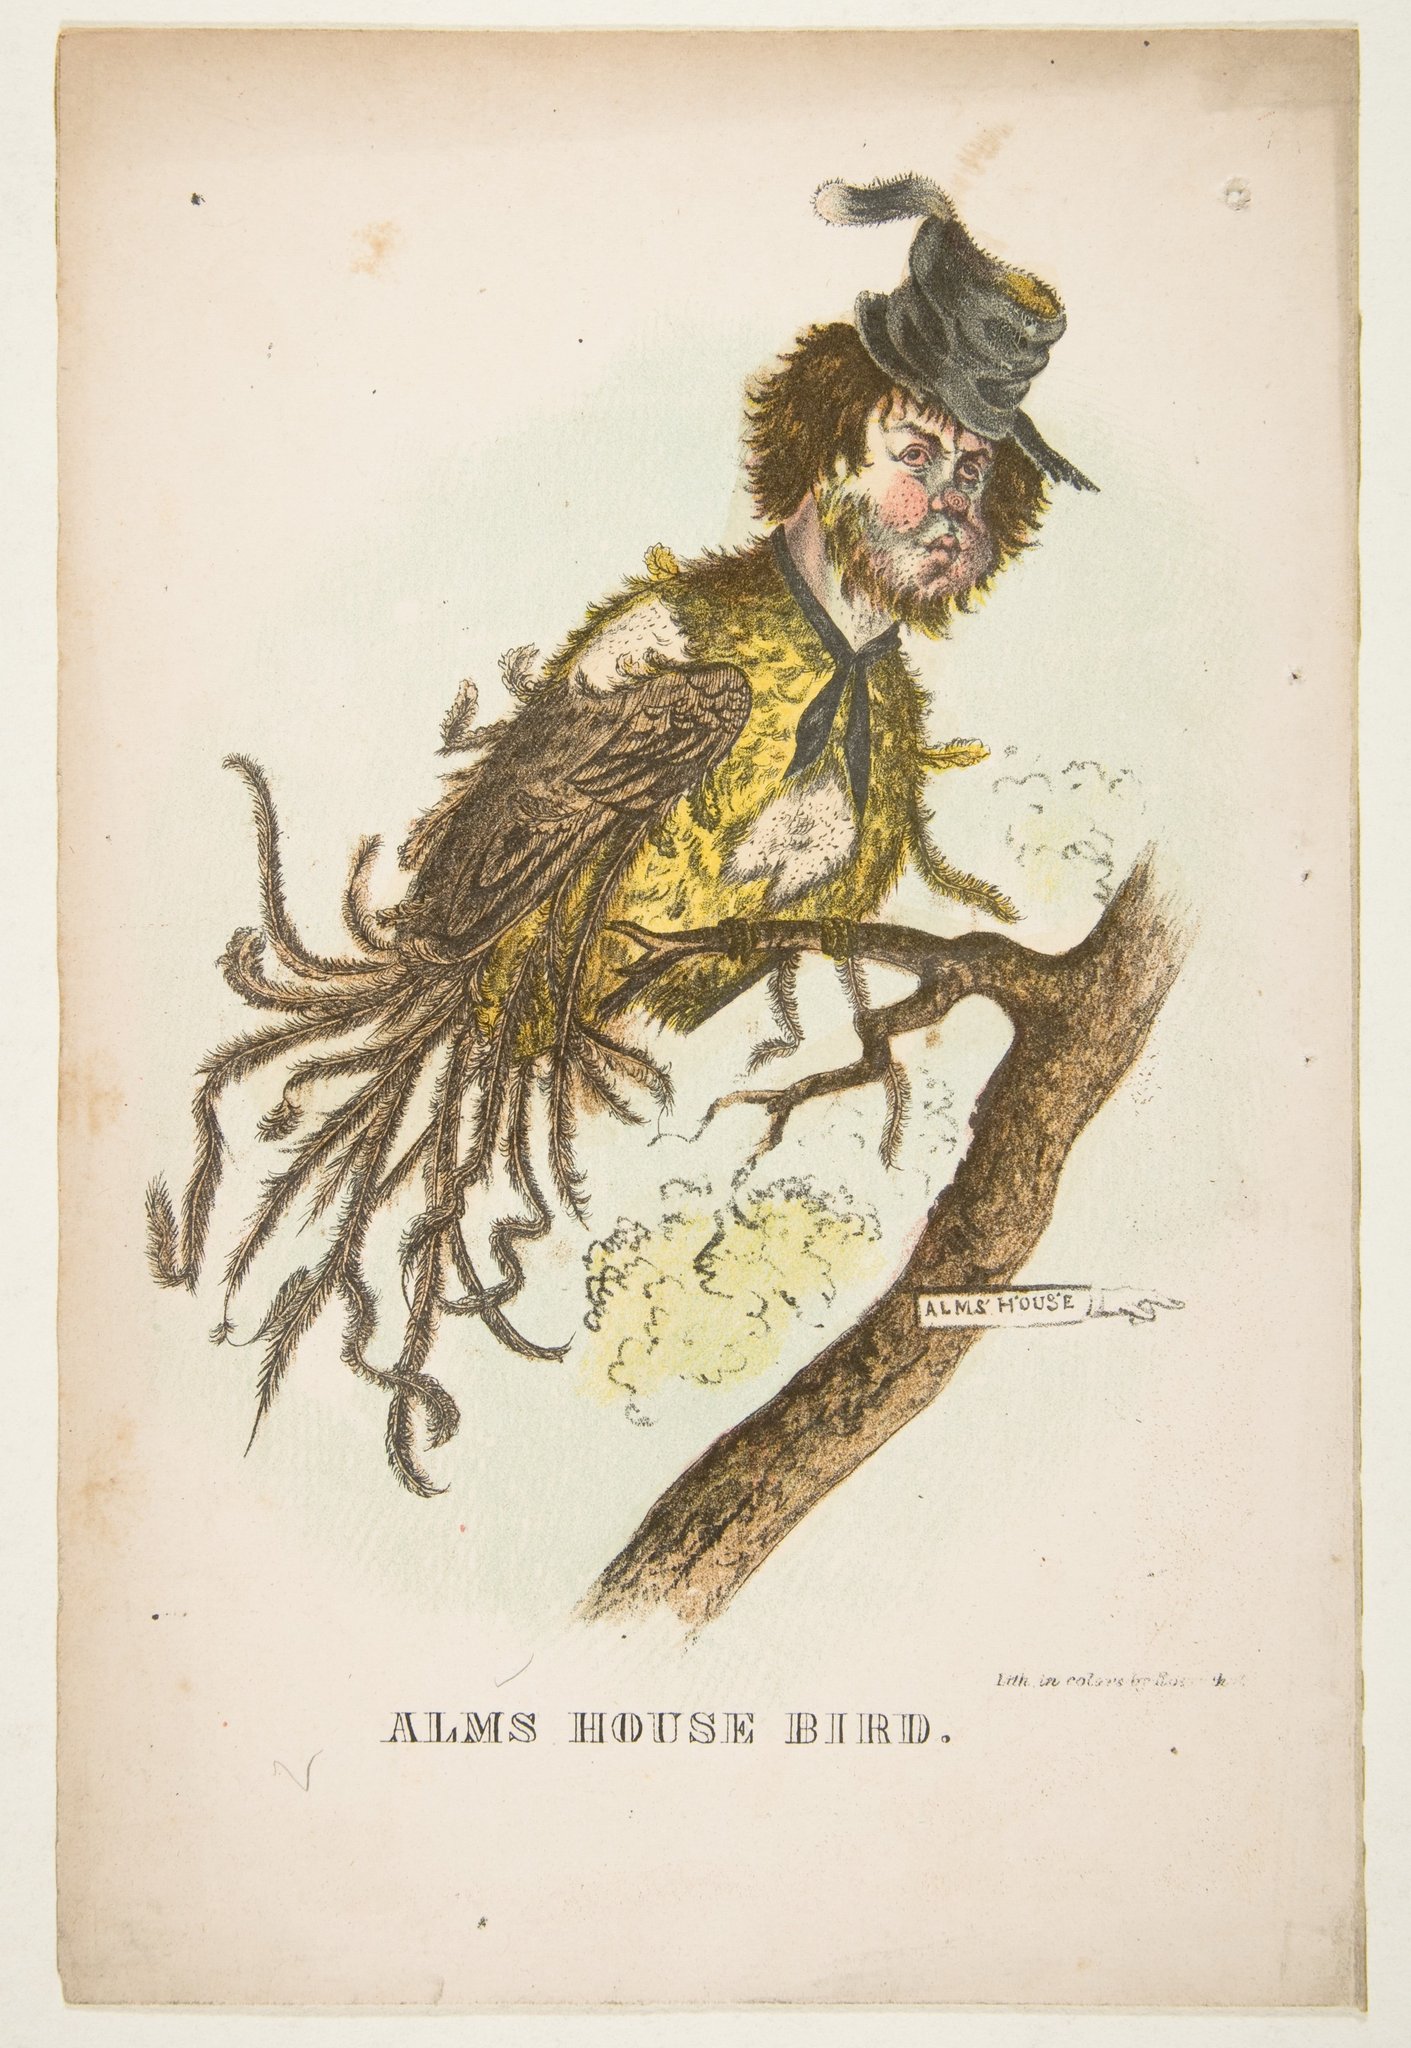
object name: print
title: Alms House Bird, from "The Comic Natural History of the Human Race"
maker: henry louis stephens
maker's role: artist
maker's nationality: american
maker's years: 1824-1882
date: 1851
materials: watercolor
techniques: lithograph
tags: satire